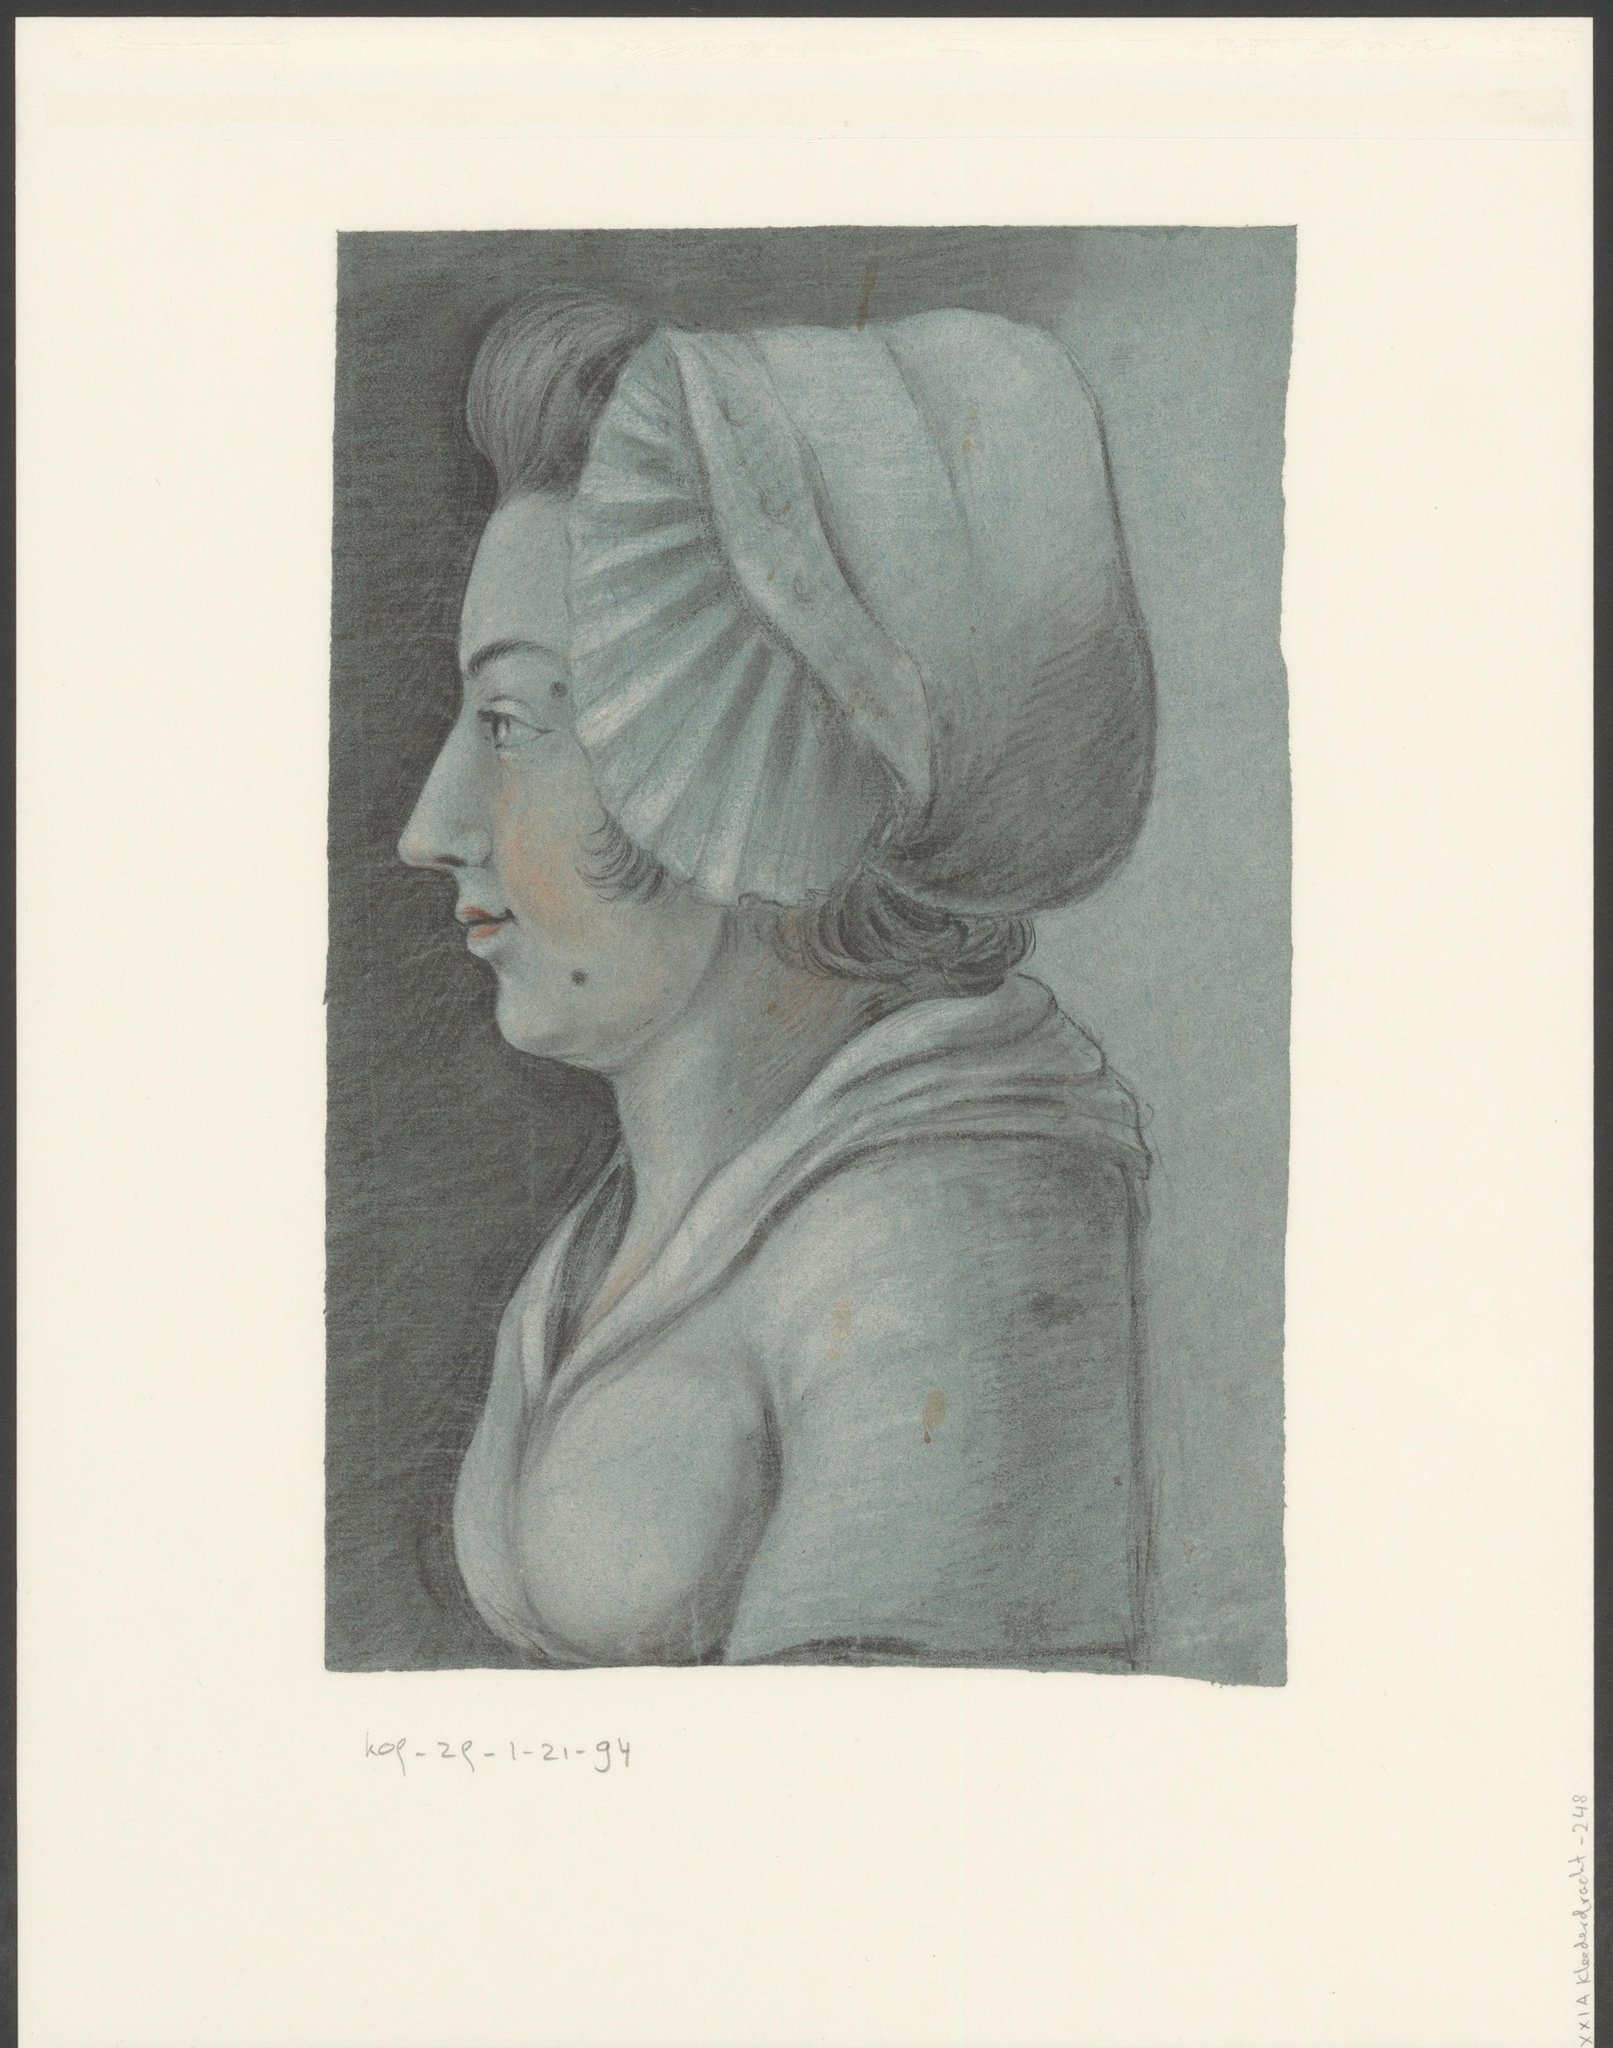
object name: drawing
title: Portret van een onbekende vrouw in klederdracht met muts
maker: Anonymous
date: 1800-1899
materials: chalk, paper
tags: historical persons not known by name - bb - woman, head-gear: cap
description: Onderwerpsrubrieken binnen de Atlas Zeden en Gewoonten: Zeden en Gewoonten in Engeren Zin, De Kleeding, Kleederdrachten (tijdvakken), De 18de eeuw (de pruikentijd). Mannen en vrouwen.